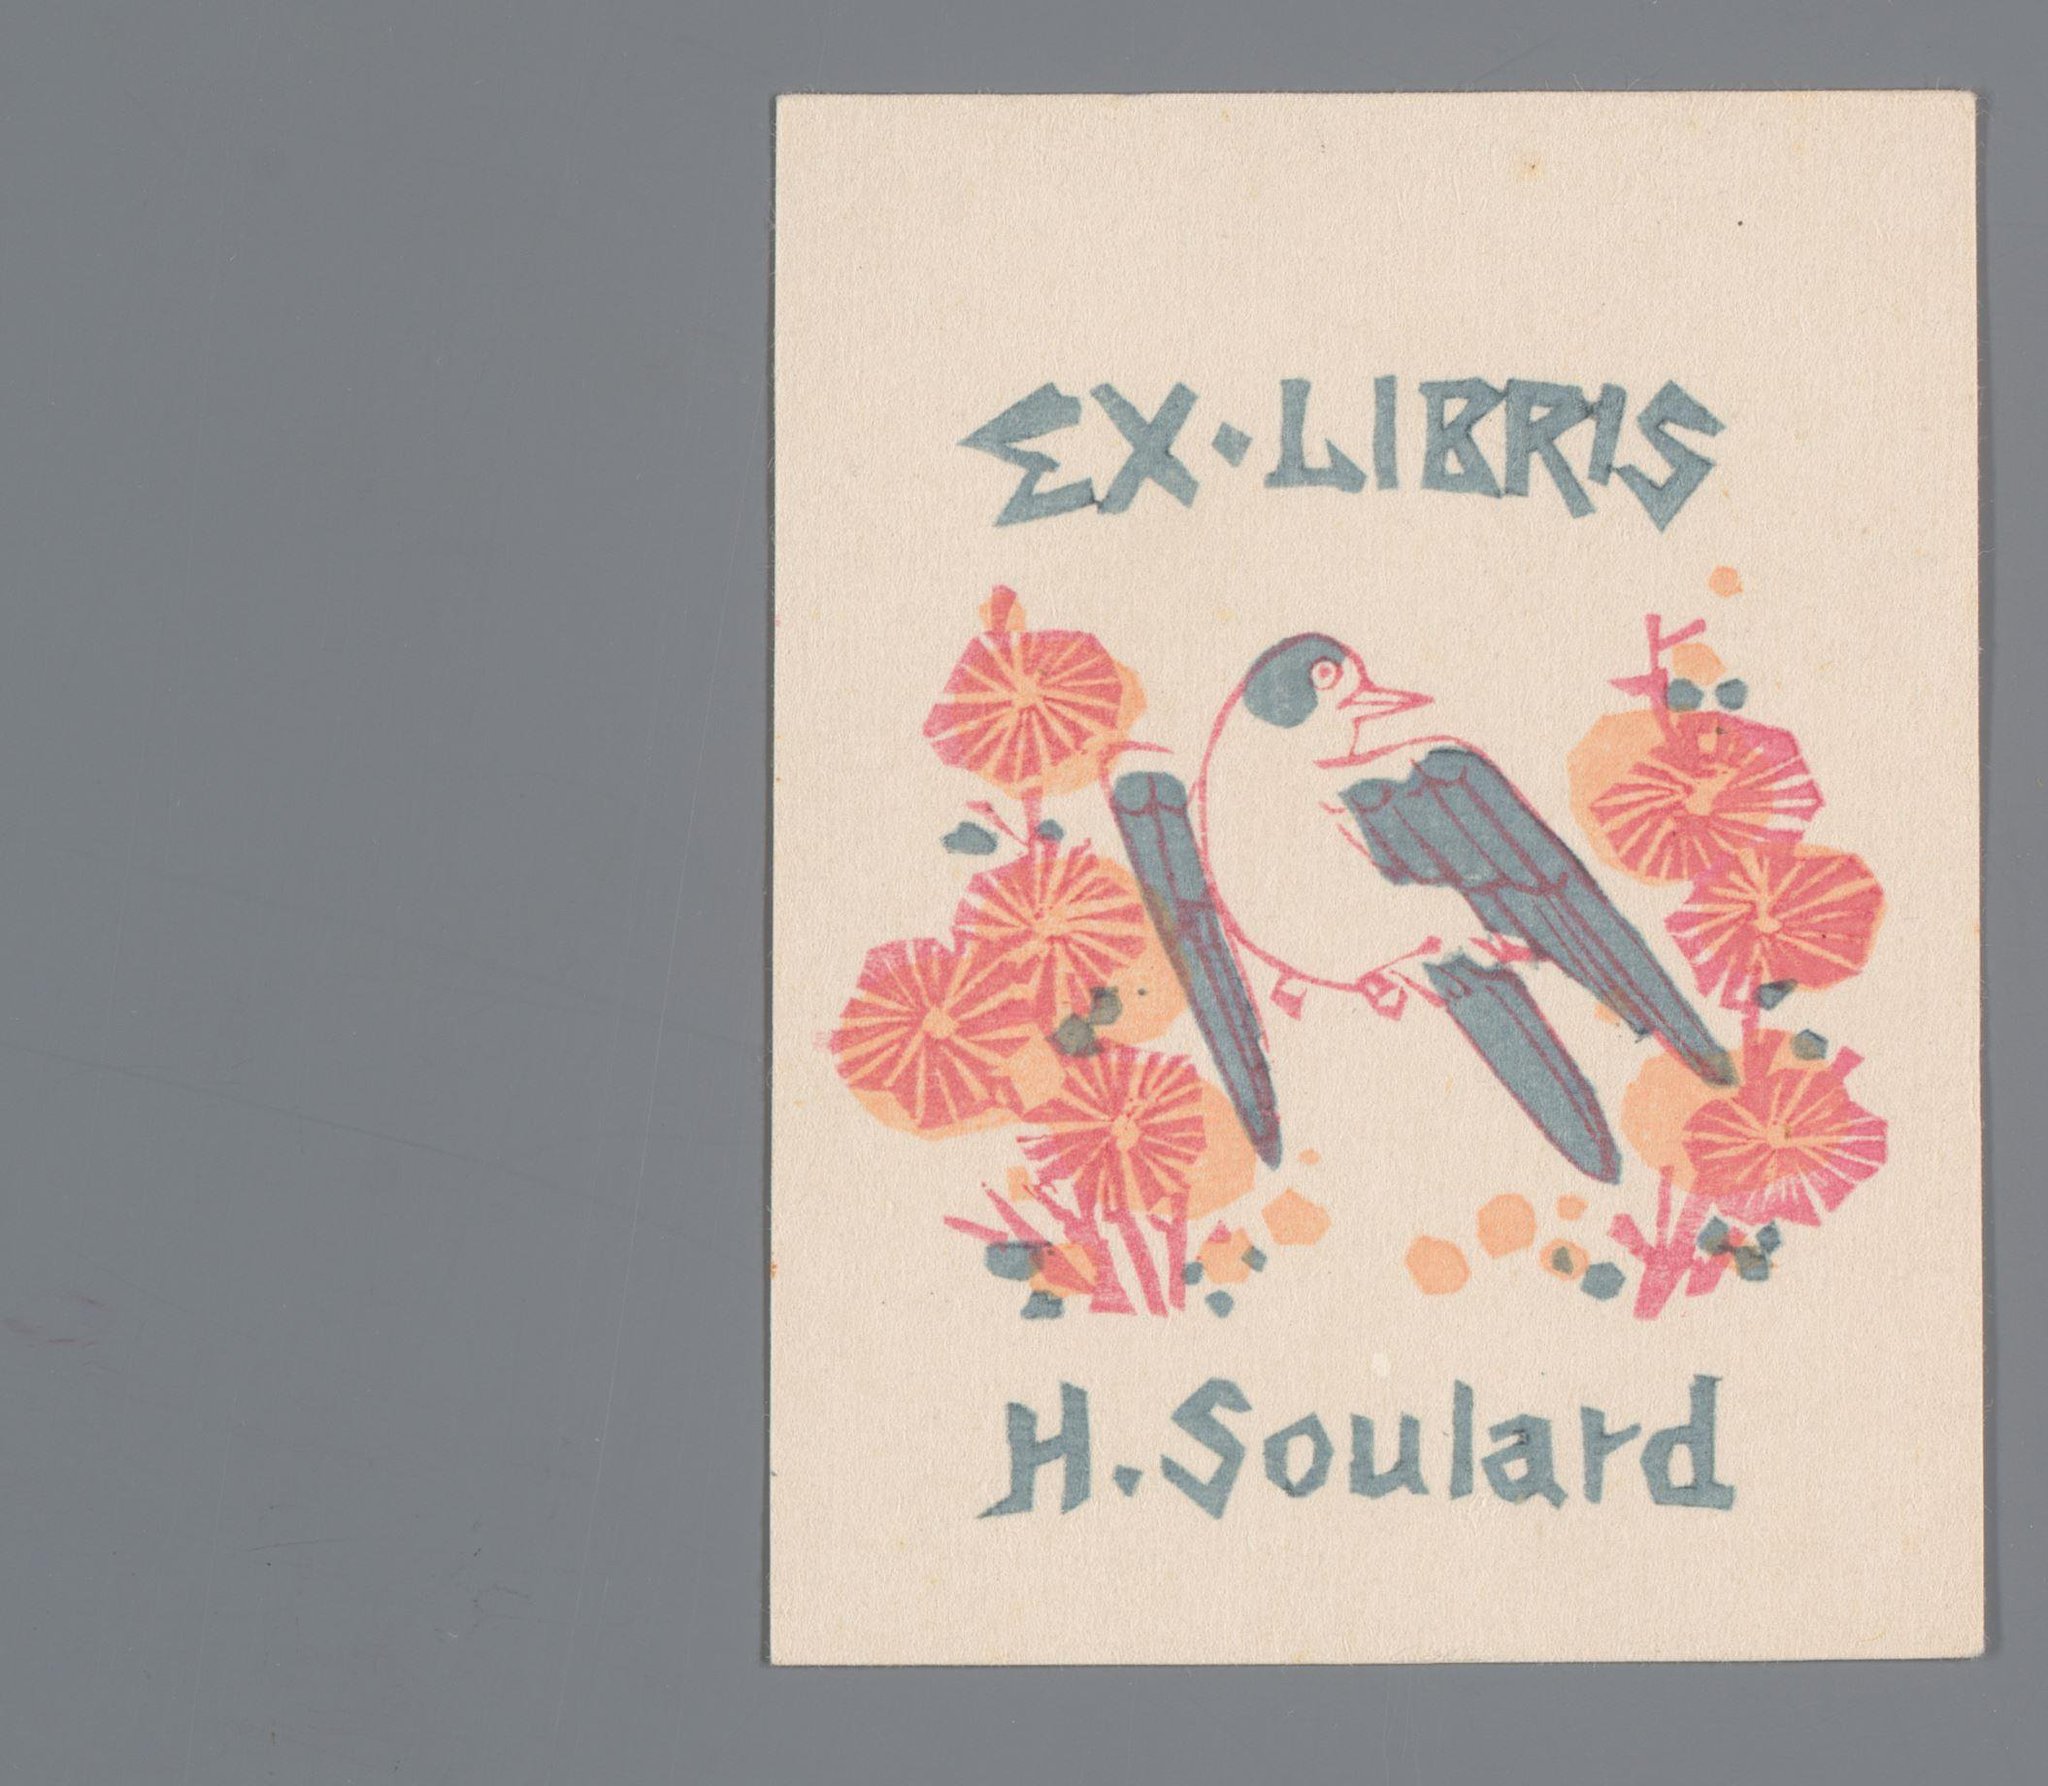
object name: bookplate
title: Ex libris van H. Soulard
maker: Anonymous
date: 1900-1999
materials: paper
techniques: woodcut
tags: birds